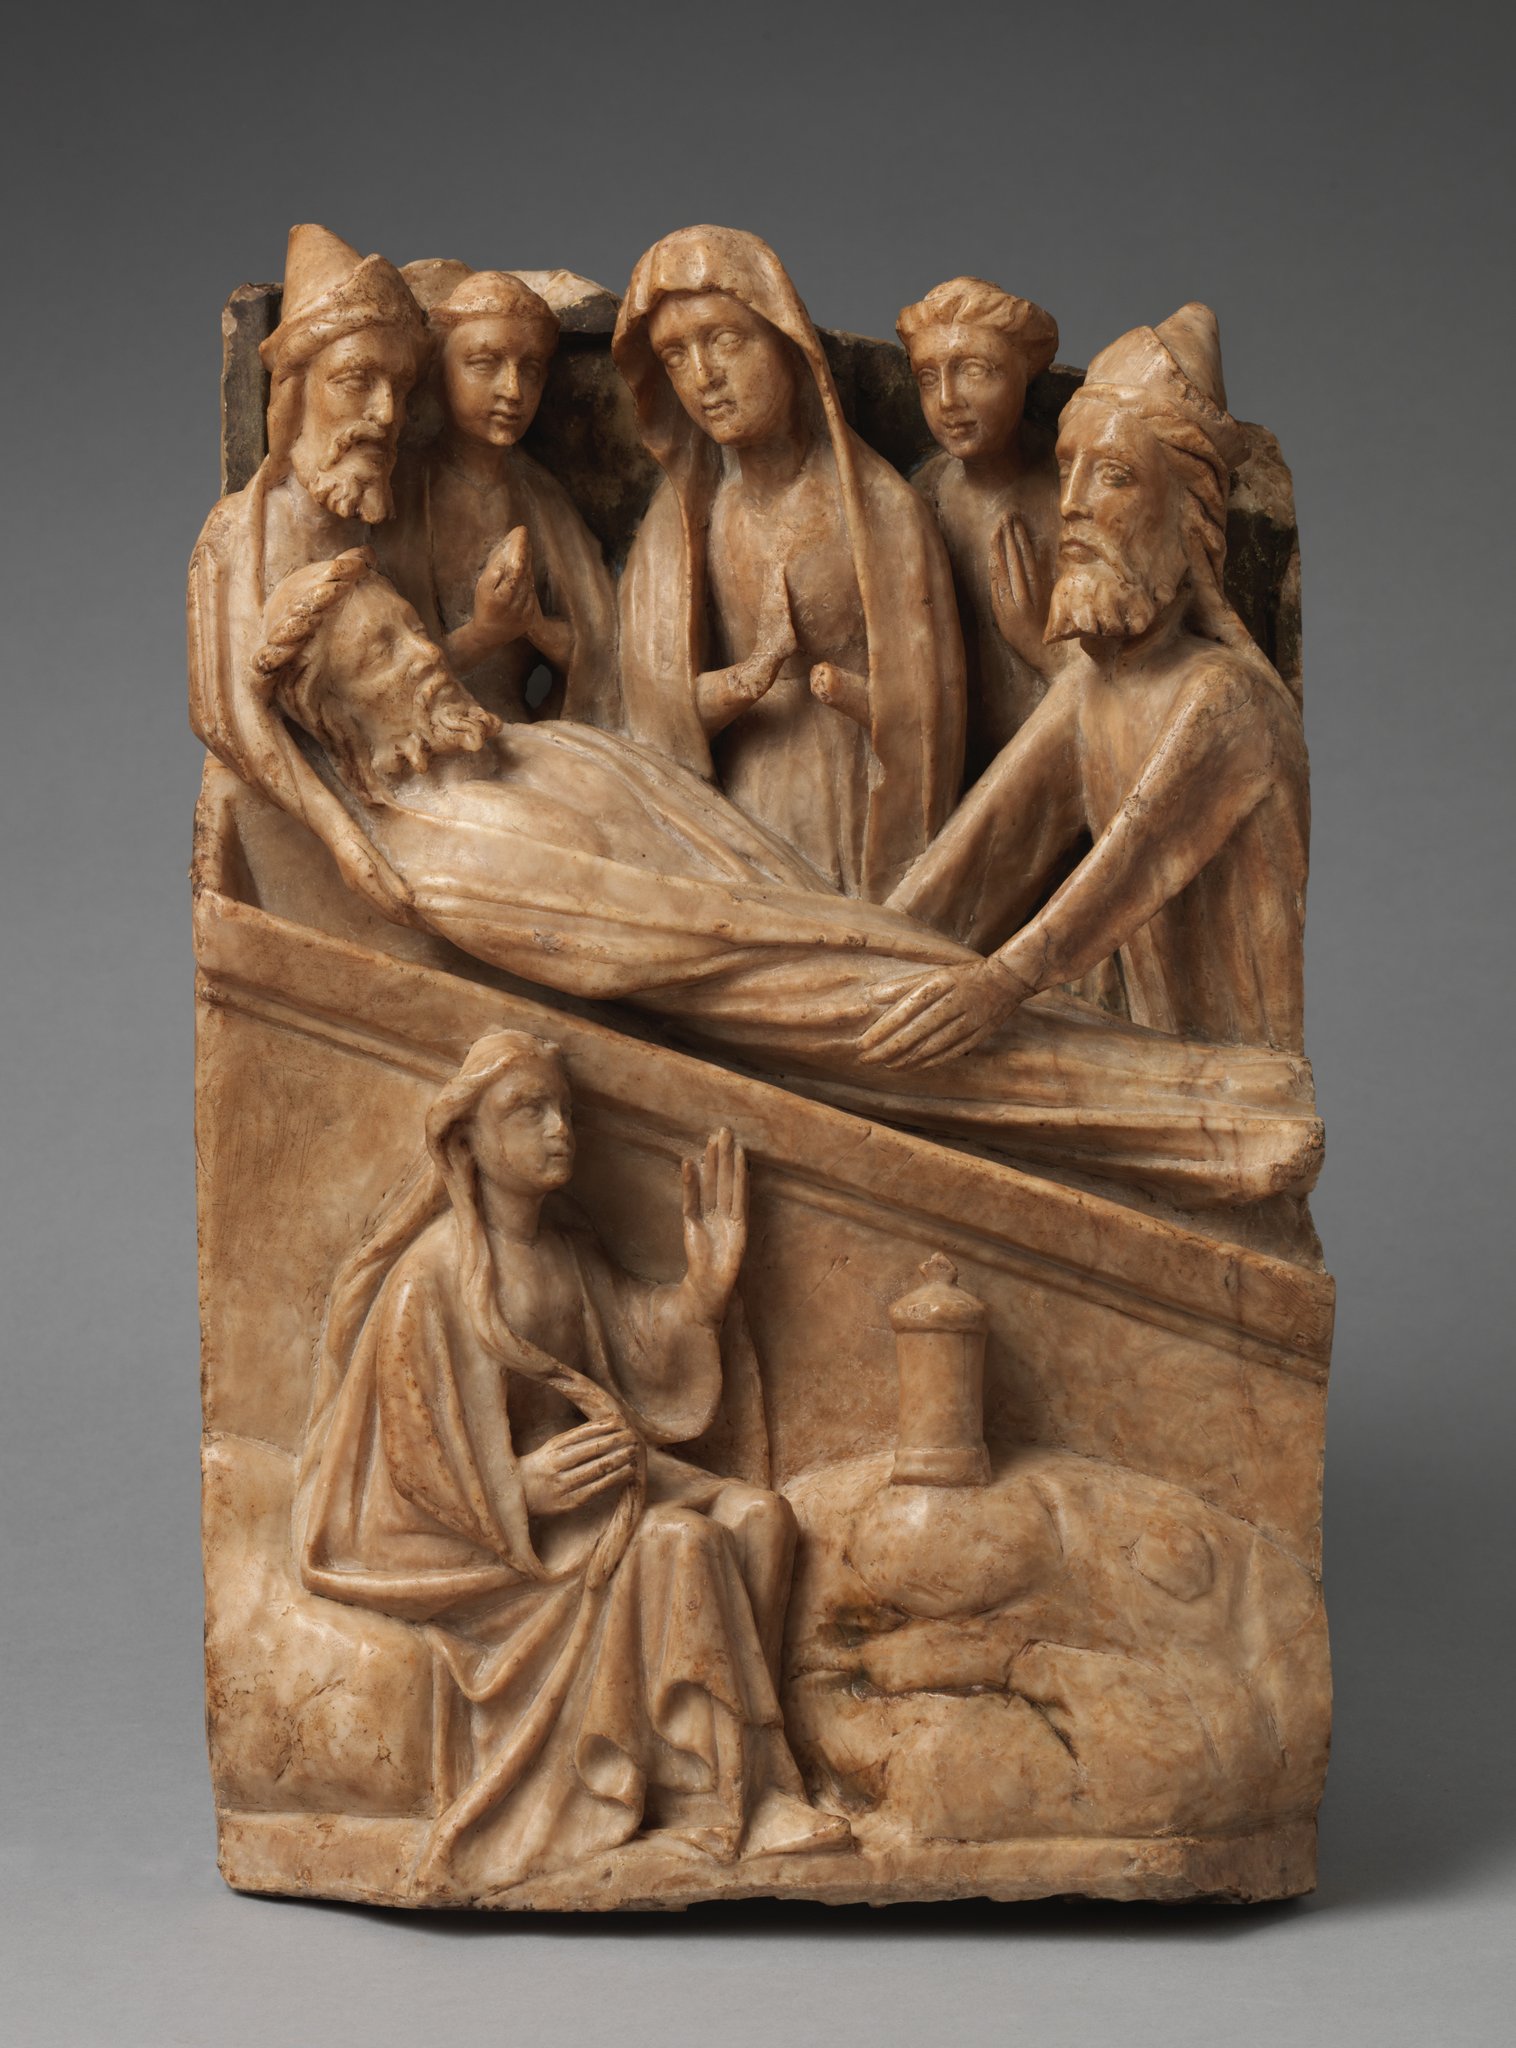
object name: panel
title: The Entombment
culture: british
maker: school of nottingham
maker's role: artist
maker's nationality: british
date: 1401-1500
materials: alabaster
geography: nottingham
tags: christ,virgin mary,entombment